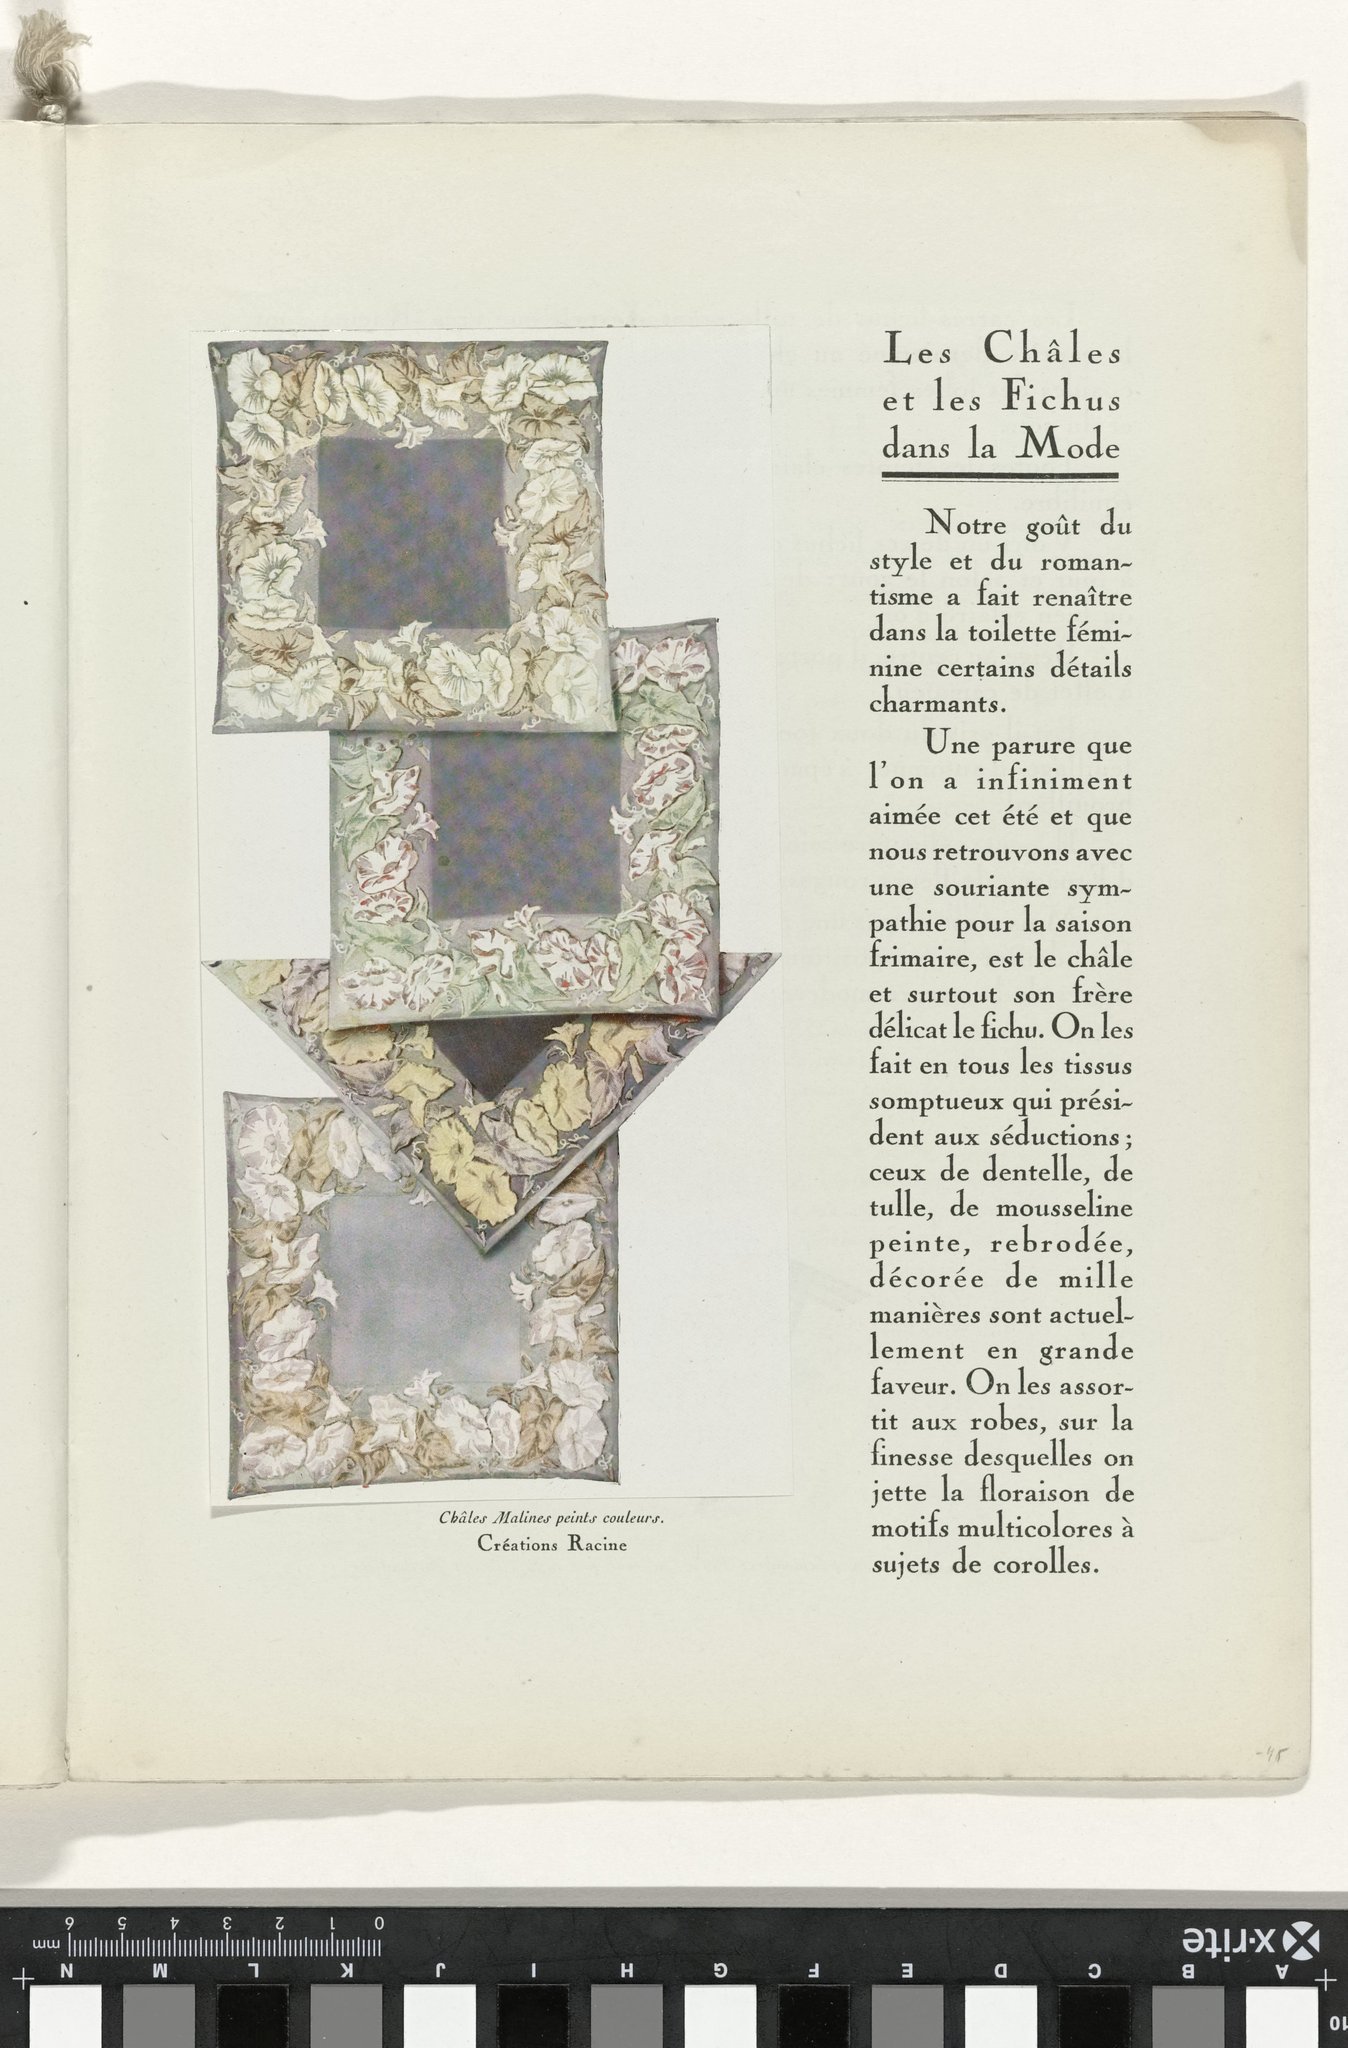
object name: fashion print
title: Art - Goût - Beauté, Feuillets de l' élégance féminine, Noël 1928, No. 100, 9e Année, p. 45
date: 1928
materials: paper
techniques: printing, lithograph, photography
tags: clothing for the upper part of the body (shawl) (+ women's clothes), fashion plates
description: Tekst met een afbeelding van vier sjaals 'Malines', aan de randen een beschilderd bloemmotief in kleur, van Racine. Pagina uit het modetijdschrift Art-Goût-Beauté (1920-1933).